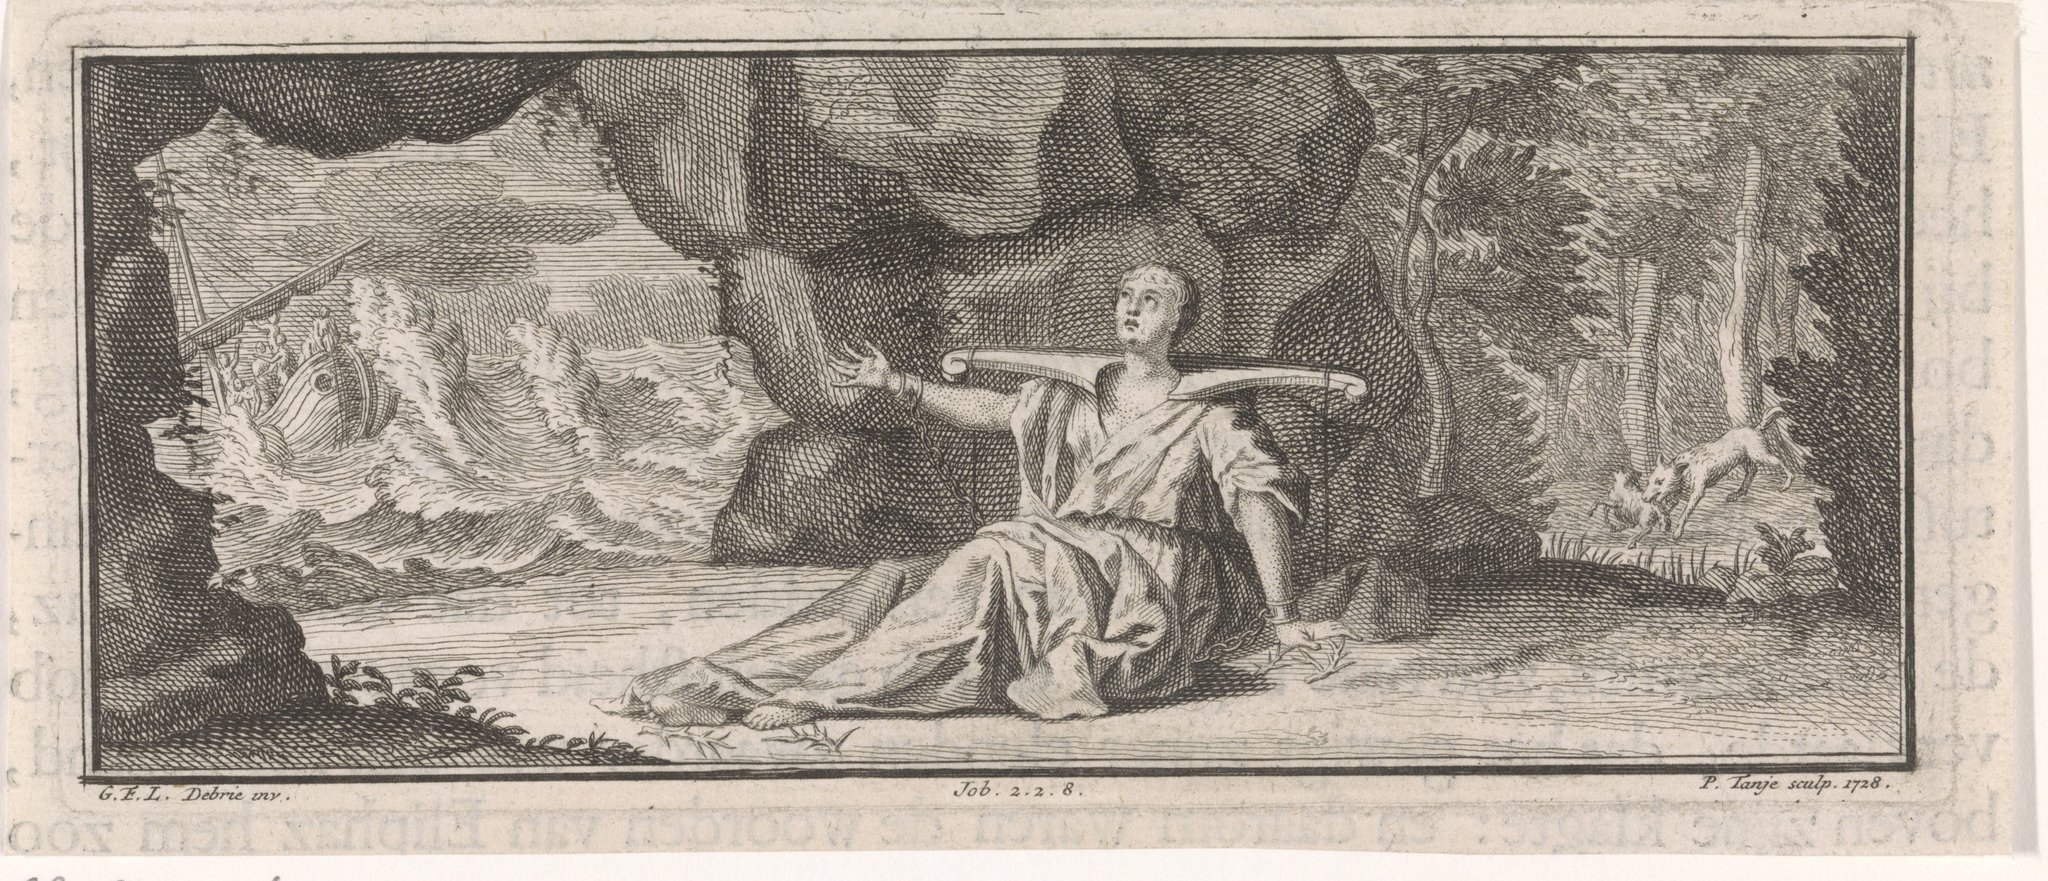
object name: book illustration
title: Job's ellende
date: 1728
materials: paper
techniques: engraving, etching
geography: amsterdam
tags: the book of job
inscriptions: collector's mark: Lugt 2228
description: Prent uit: Taferelen der voornaamste geschiedenissen van het Oude en Nieuwe Testament, en andere boeken, bij de Heilige Schrift gevoegt, door de vermaarde kunstenaars Hoet, Houbraken, en Picart getekent (...) en met beschrijvingen uitgebreid. Den Haag: Pieter de Hondt, 1728, dl. 2, p. 261.